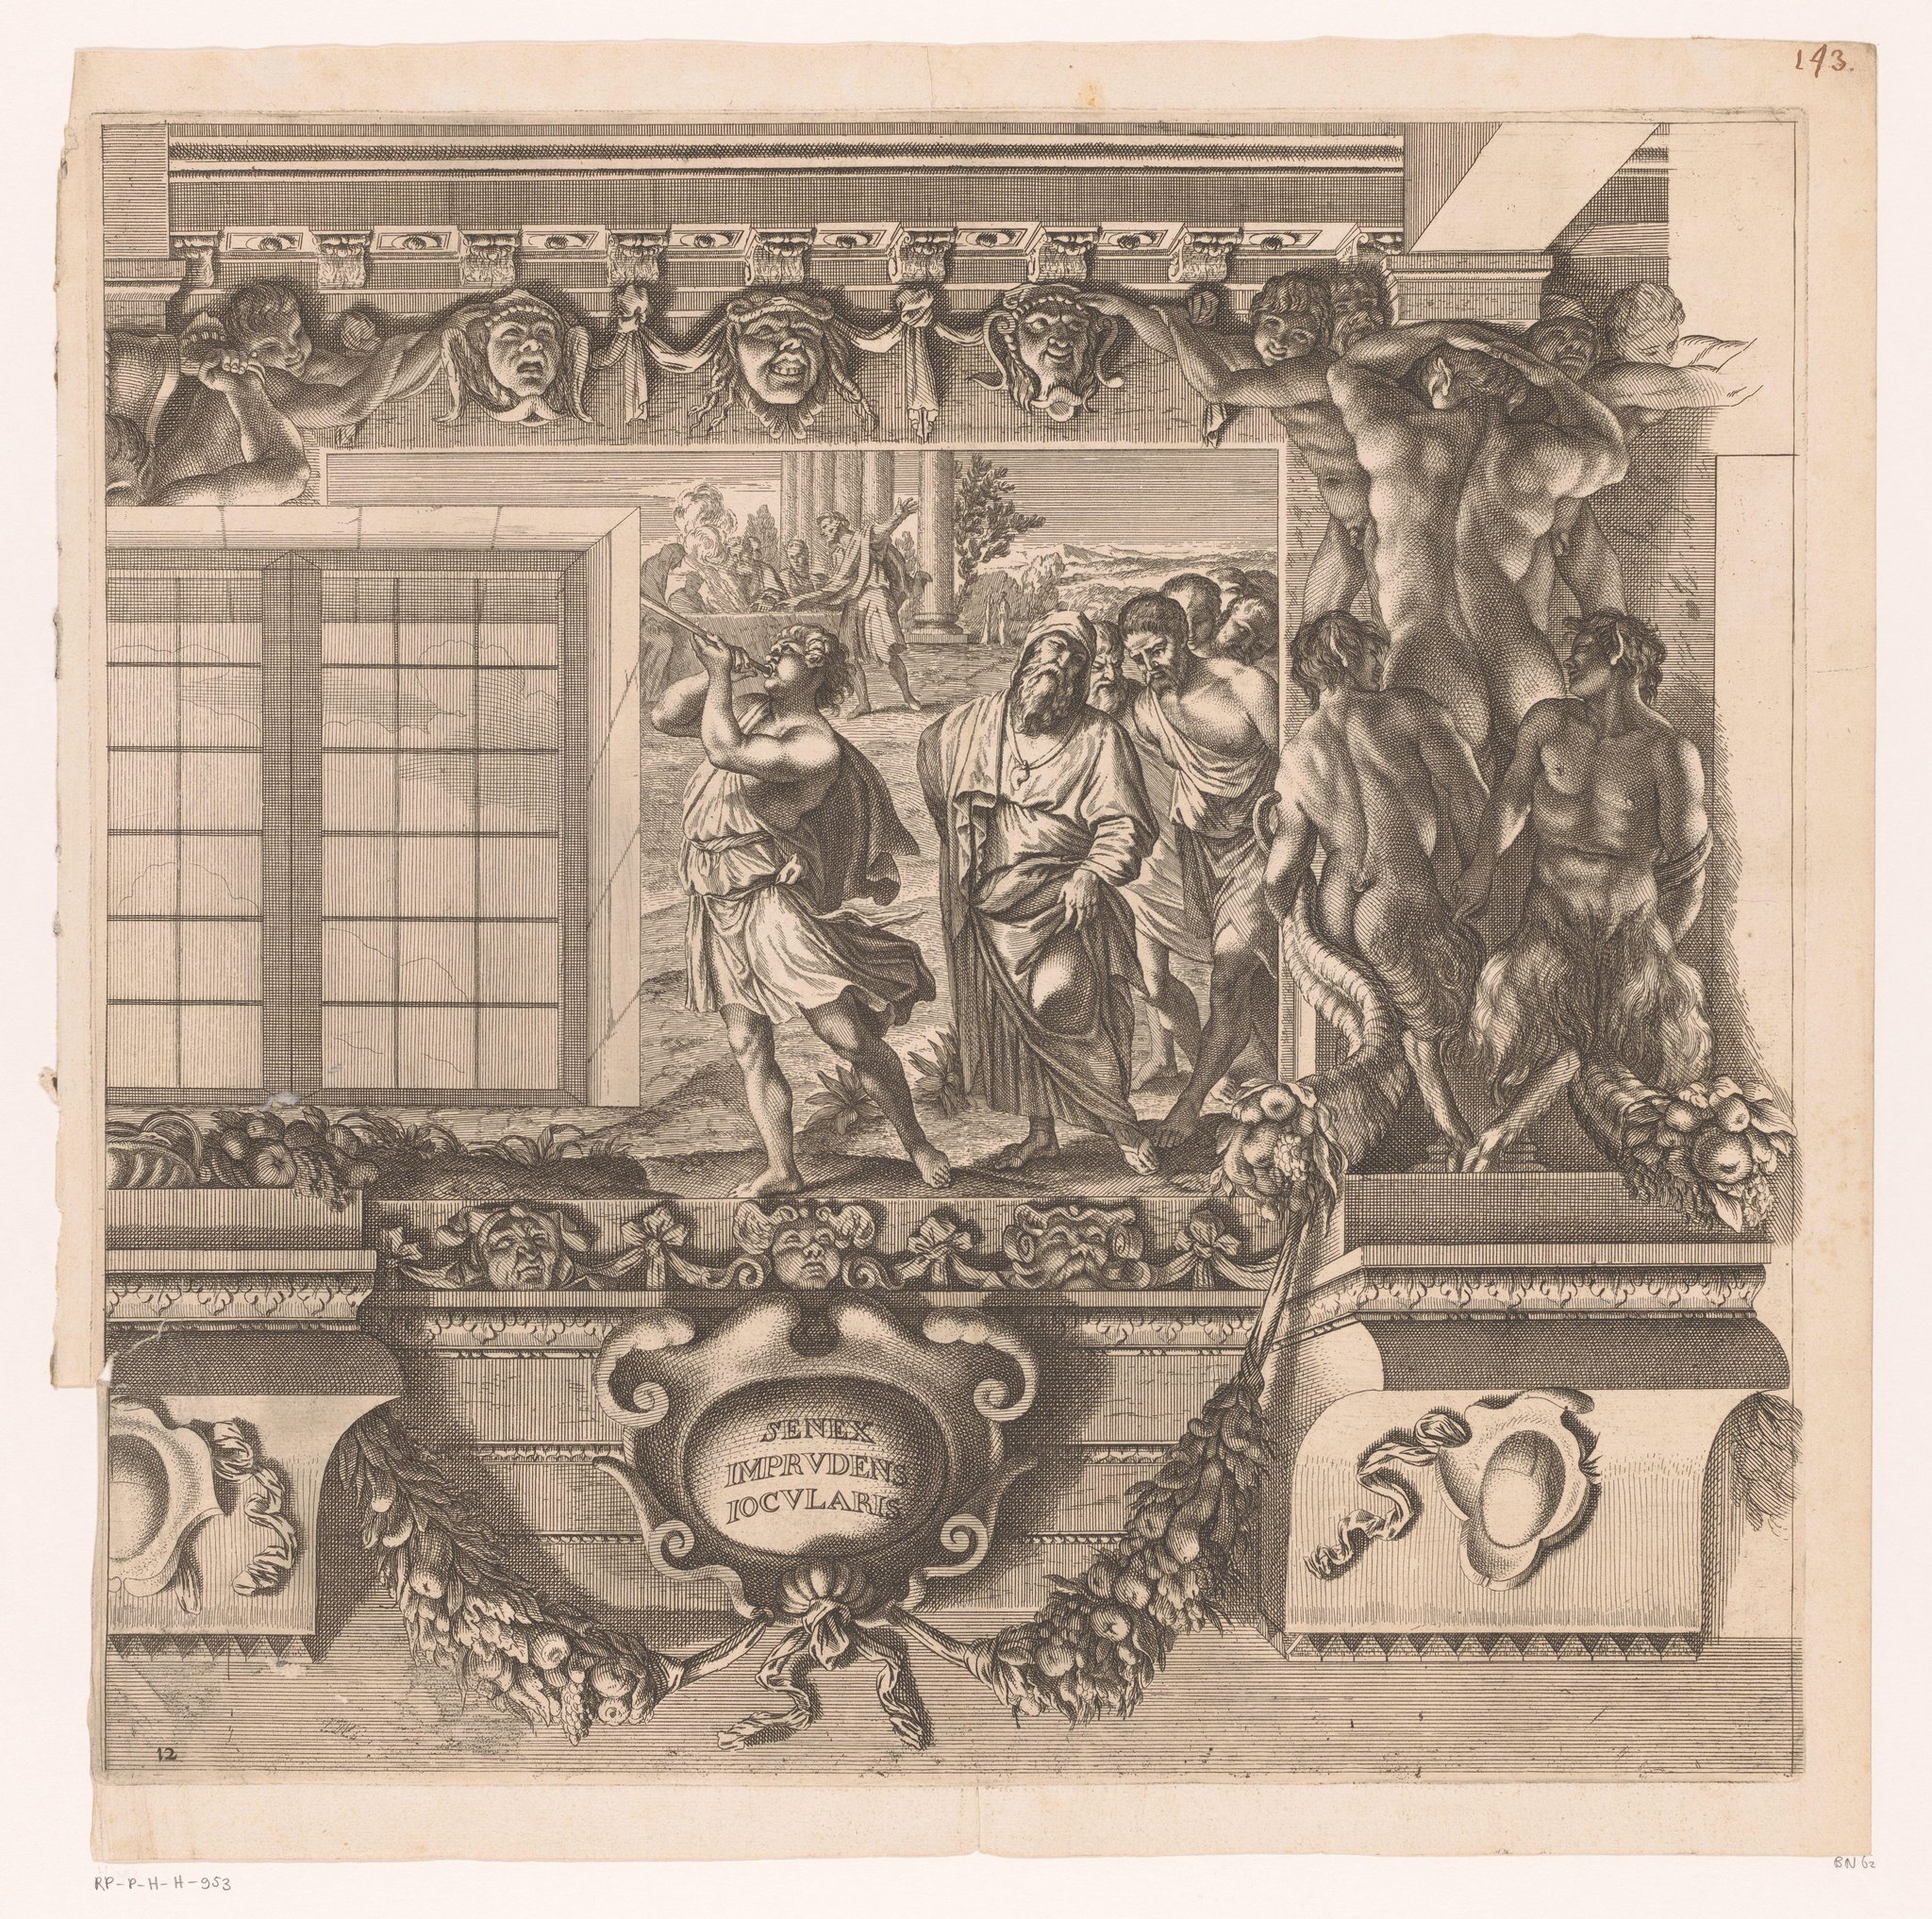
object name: print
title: Verhaal van Romulus en Remus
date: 1659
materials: paper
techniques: engraving, etching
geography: bologna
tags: rome at war with the neighbouring nations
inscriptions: collector's mark: Lugt 11, number: ‘143.’, number: ‘144.’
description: Maakt deel uit van een 14-delige serie met scènes uit het verhaal van Romulus en Remus naar ontwerpen door de familie Carracci voor het Palazzo Magnani te Bologna. Prent 1 t/m 7 zijn in prent gebracht door Lepautre en Boulanger en prent 8 t/m 14 door De Châtillon.